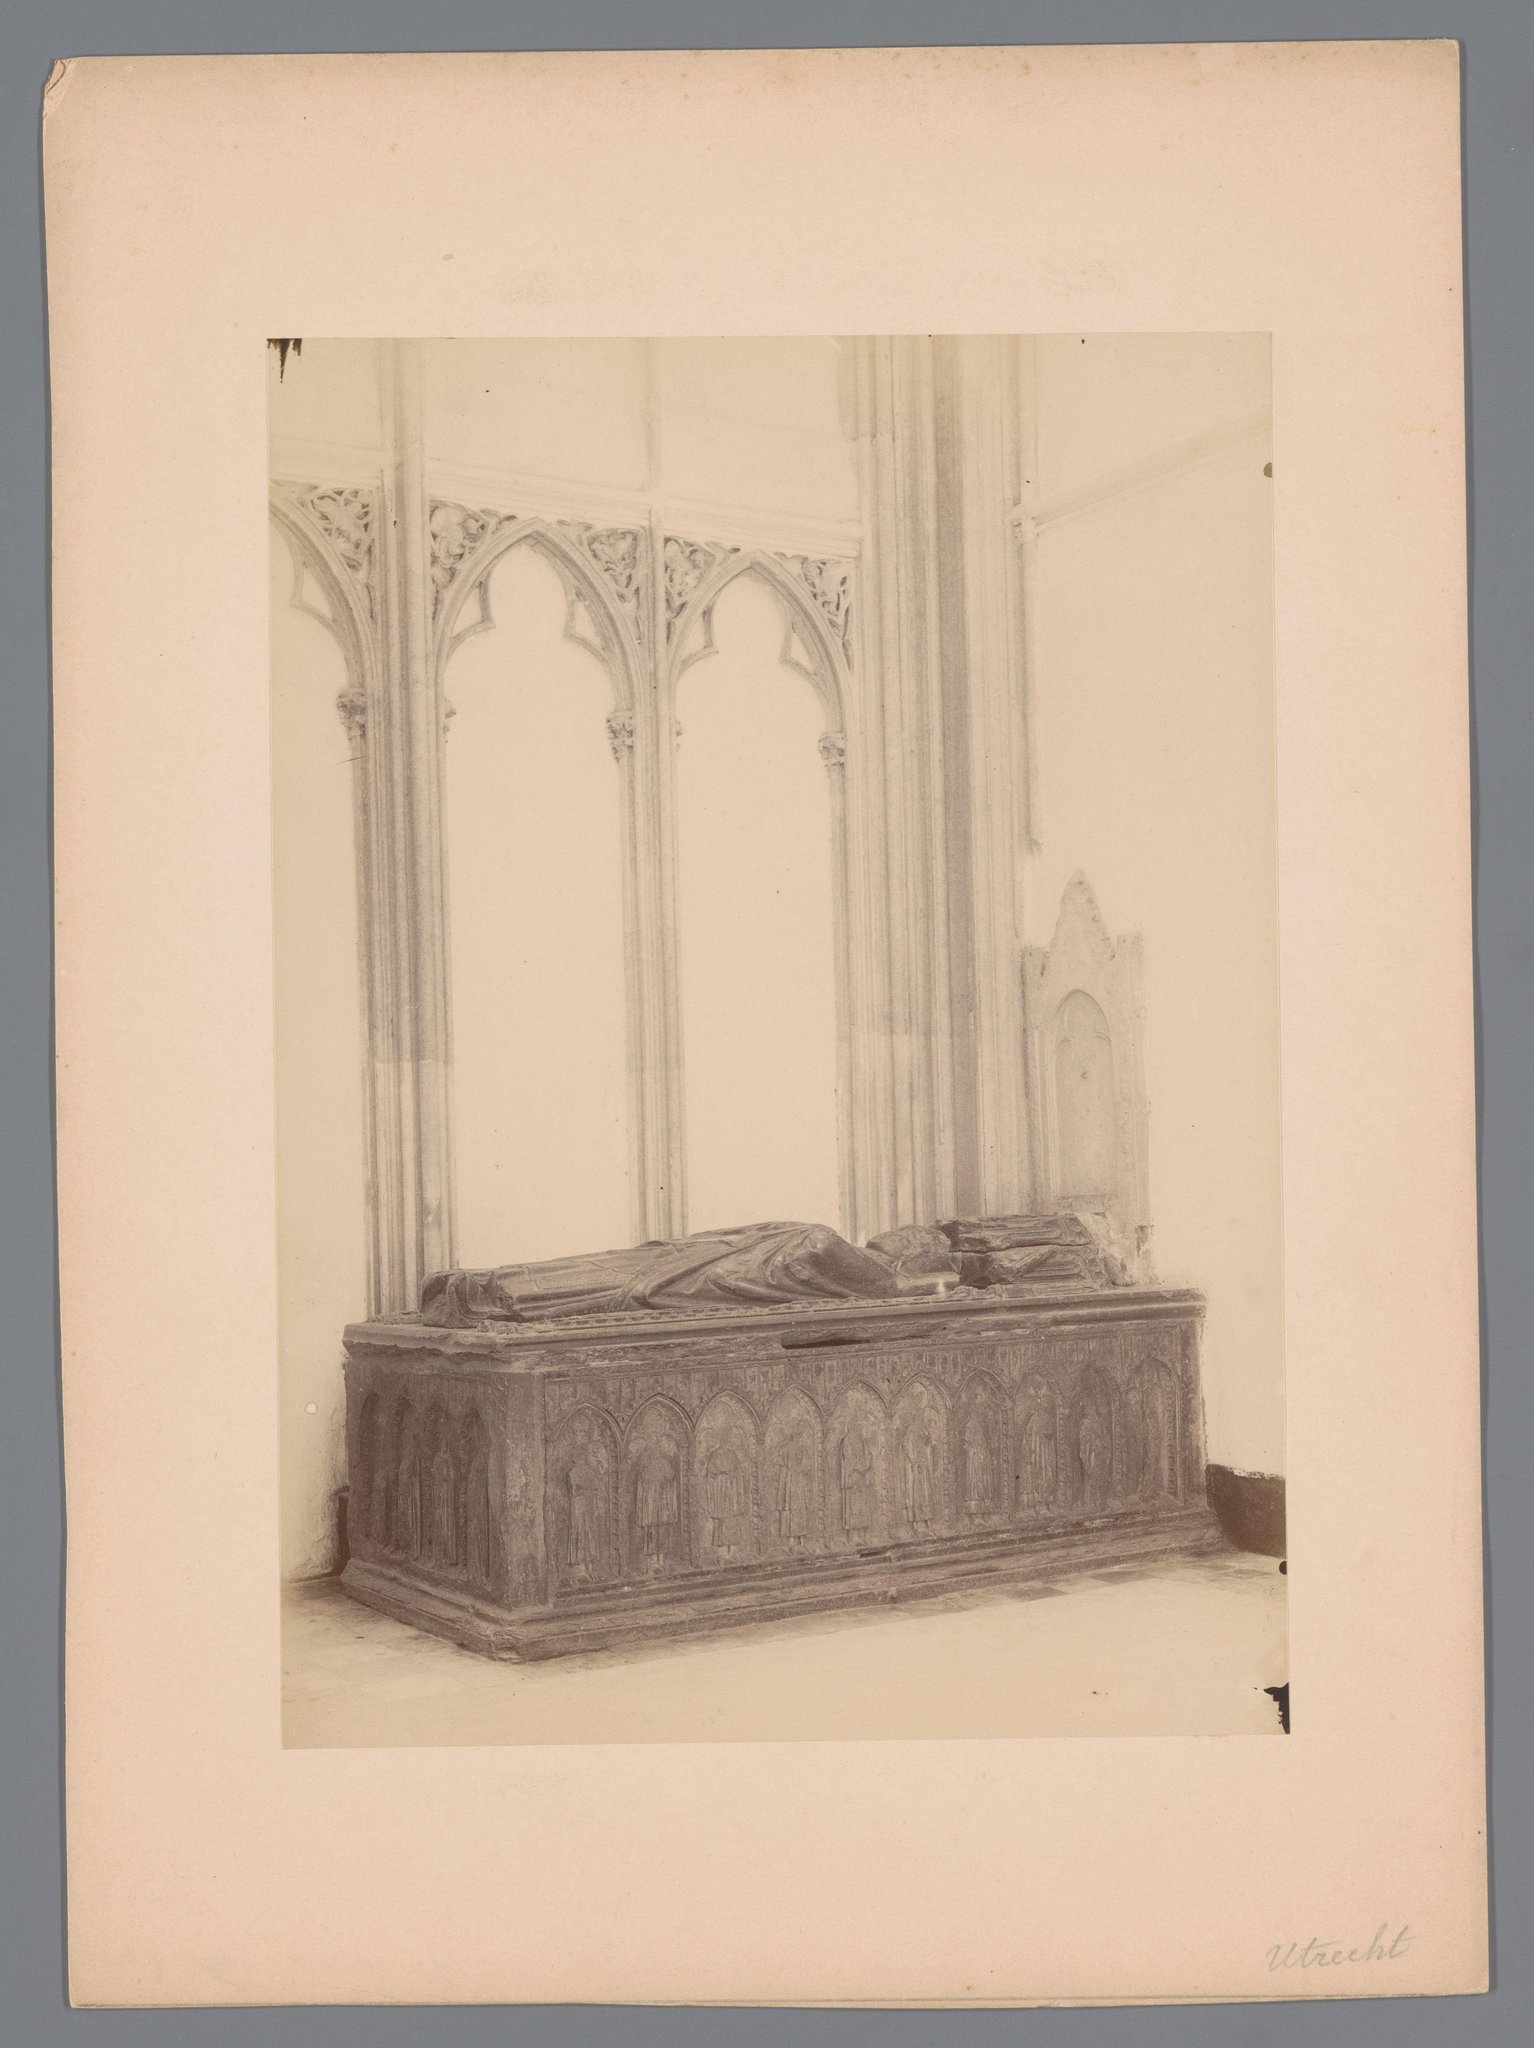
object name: photograph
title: Grafmonument van Gwijde van Avesnes in de Dom van Utrecht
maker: anoniem (monumentenzorg)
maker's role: fotograaf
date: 1891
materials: cardboard, photographic support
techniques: albumen print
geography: utrecht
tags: interior of church, grave-building, monumental tomb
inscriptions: annotation: ‘Utrecht’, annotation: ‘Domkerk te Utrecht/ graftombe van Bisschop Guy van Avesnes/ sept 1891’